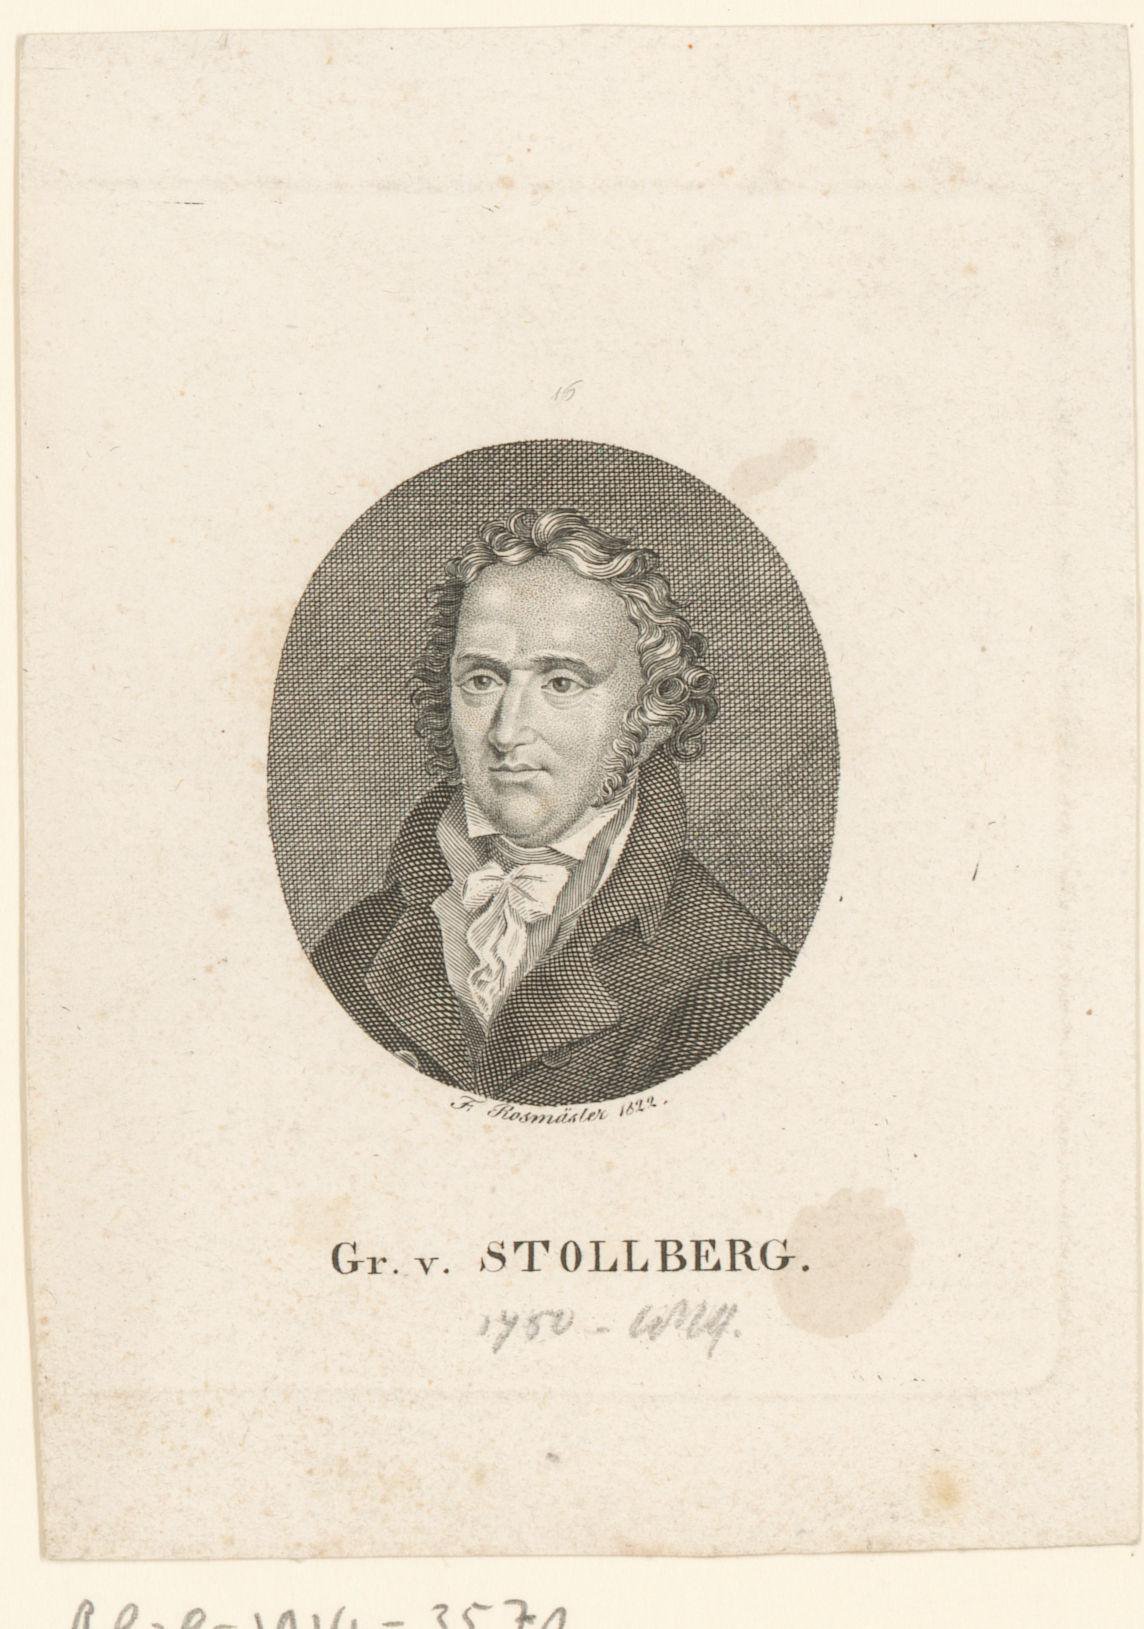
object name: print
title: Portret van Friedrich Leopold, graaf van Stolberg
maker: friedrich rossmässler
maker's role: print maker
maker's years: 1775-1858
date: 1822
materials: paper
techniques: engraving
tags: historical persons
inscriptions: collector's mark: Lugt 2228, date